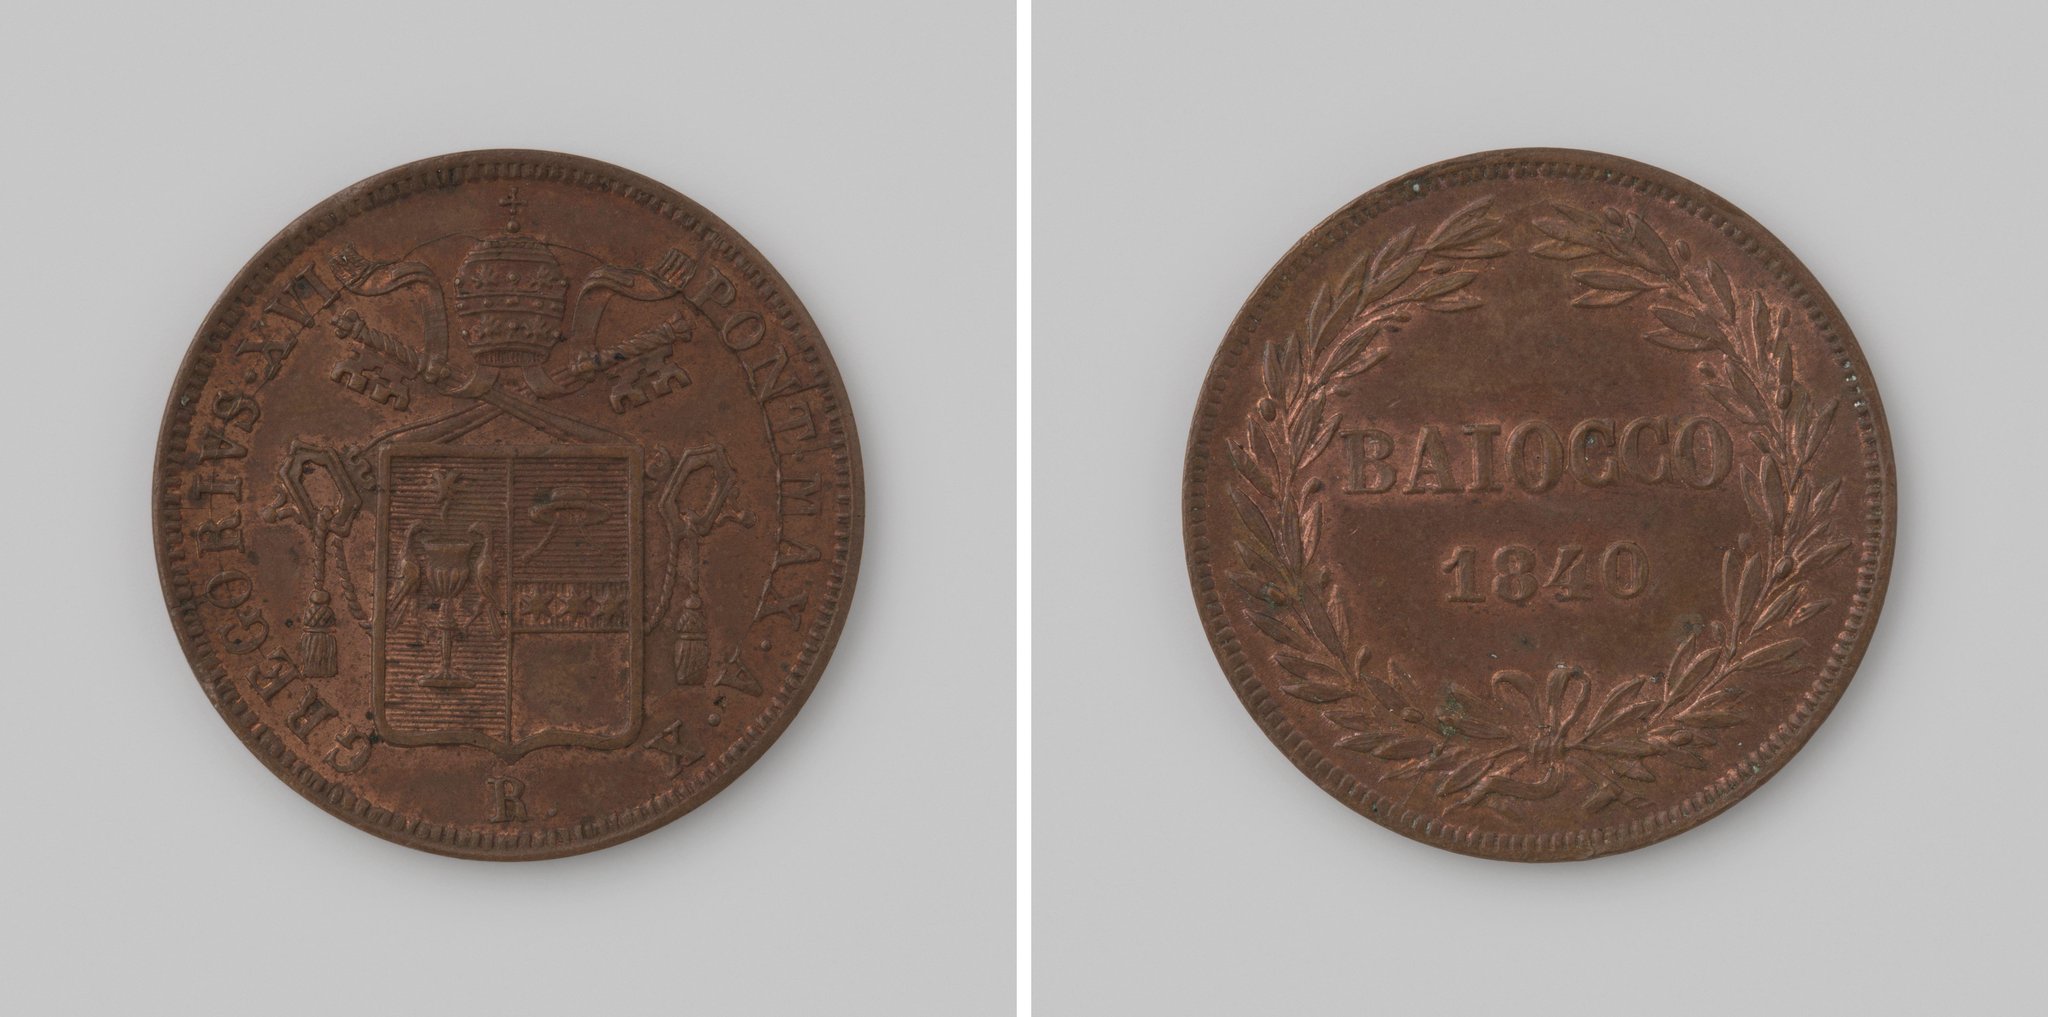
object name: coin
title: Baiocco uit de kerkelijke Staat van paus Gregorius XVI, 1840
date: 1840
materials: copper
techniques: striking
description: Koperen munt. Voorzijde: versierd wapenschild, waarboven twee gekruiste sleutels. Daarboven tiara. Keerzijde: binnen twee samengebonden takken waarde-aanduiding in een regel, waaronder jaartal. Gladde rand.